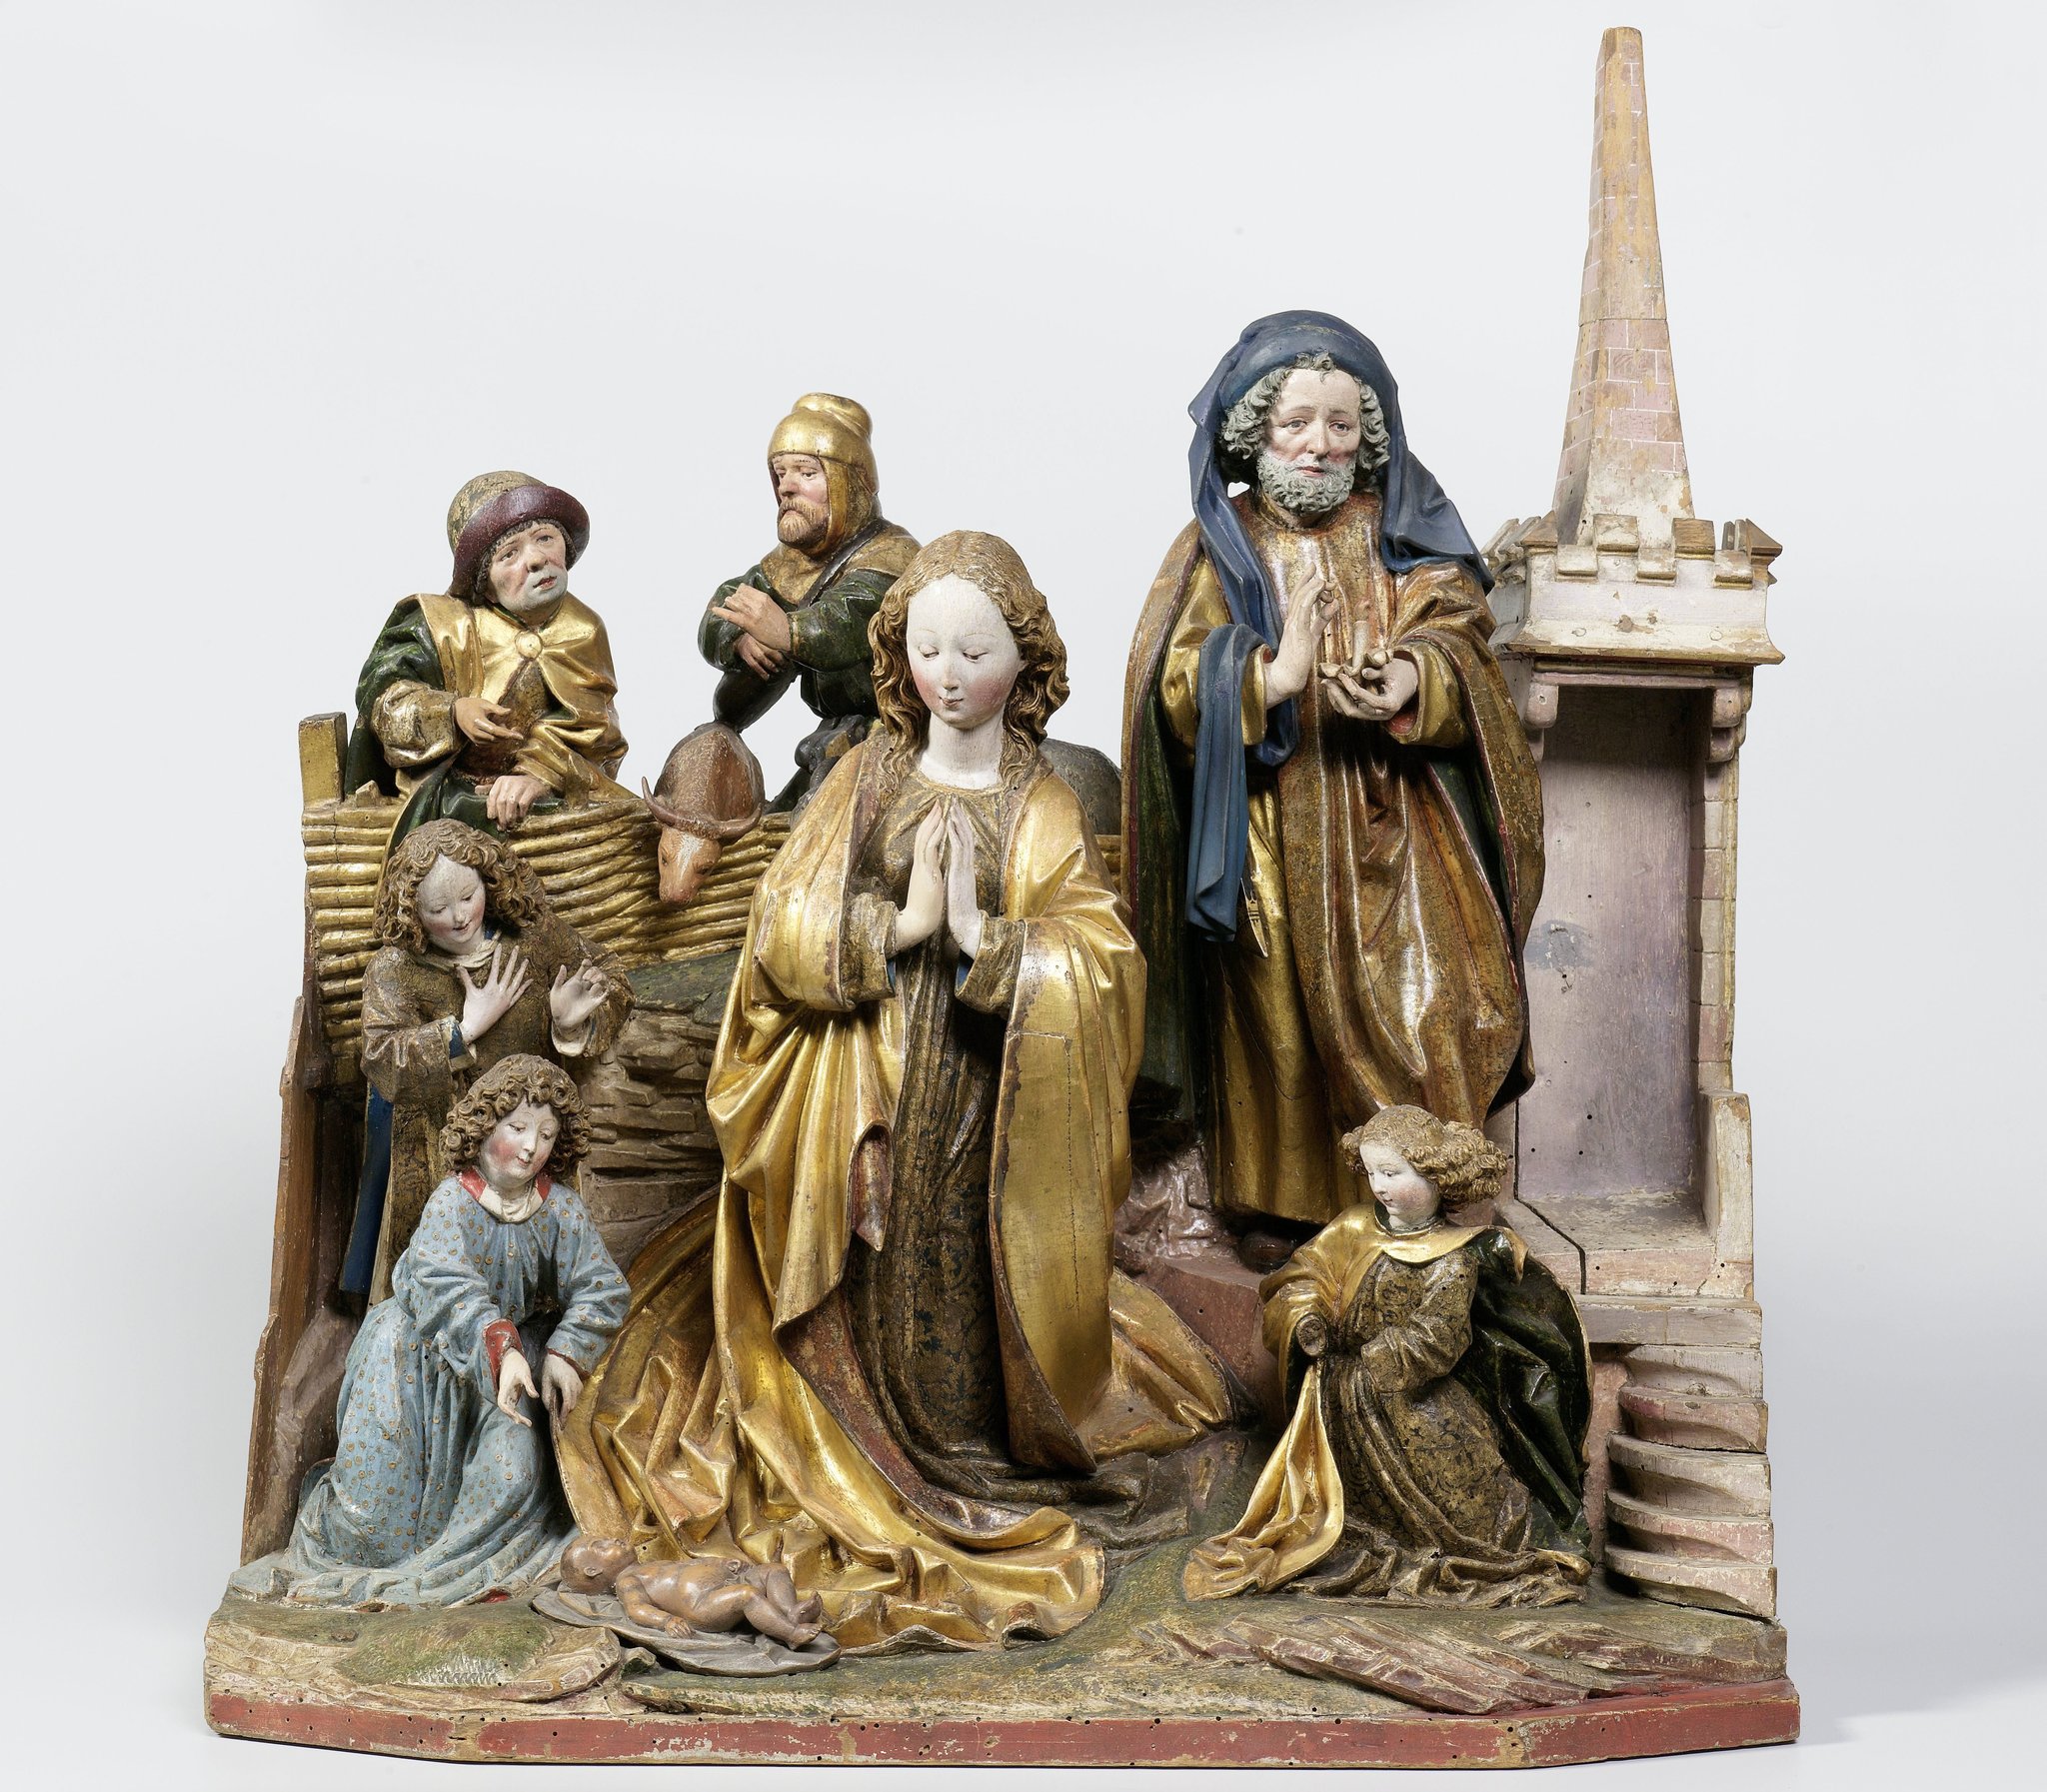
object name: sculpture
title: The Nativity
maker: hans kamensetzer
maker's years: -1487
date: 1470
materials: wood, linen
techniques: gilding, polychromy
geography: straatsburg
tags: adoration of the christ-child by the shepherds; mary and joseph present, adoration of the christ-child by mary and joseph (+ angel(s))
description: The style of the famous Dutch sculptor Nicolaas Gerhaert van Leyden is reflected in the painstaking, calligraphic rendering of these figures, with their grace and spatial coherence. Van Leyden worked in Strasbourg and had a profound influence on Late Gothic German sculpture. The artist who made this beguiling nativity group was probably a pupil of his.